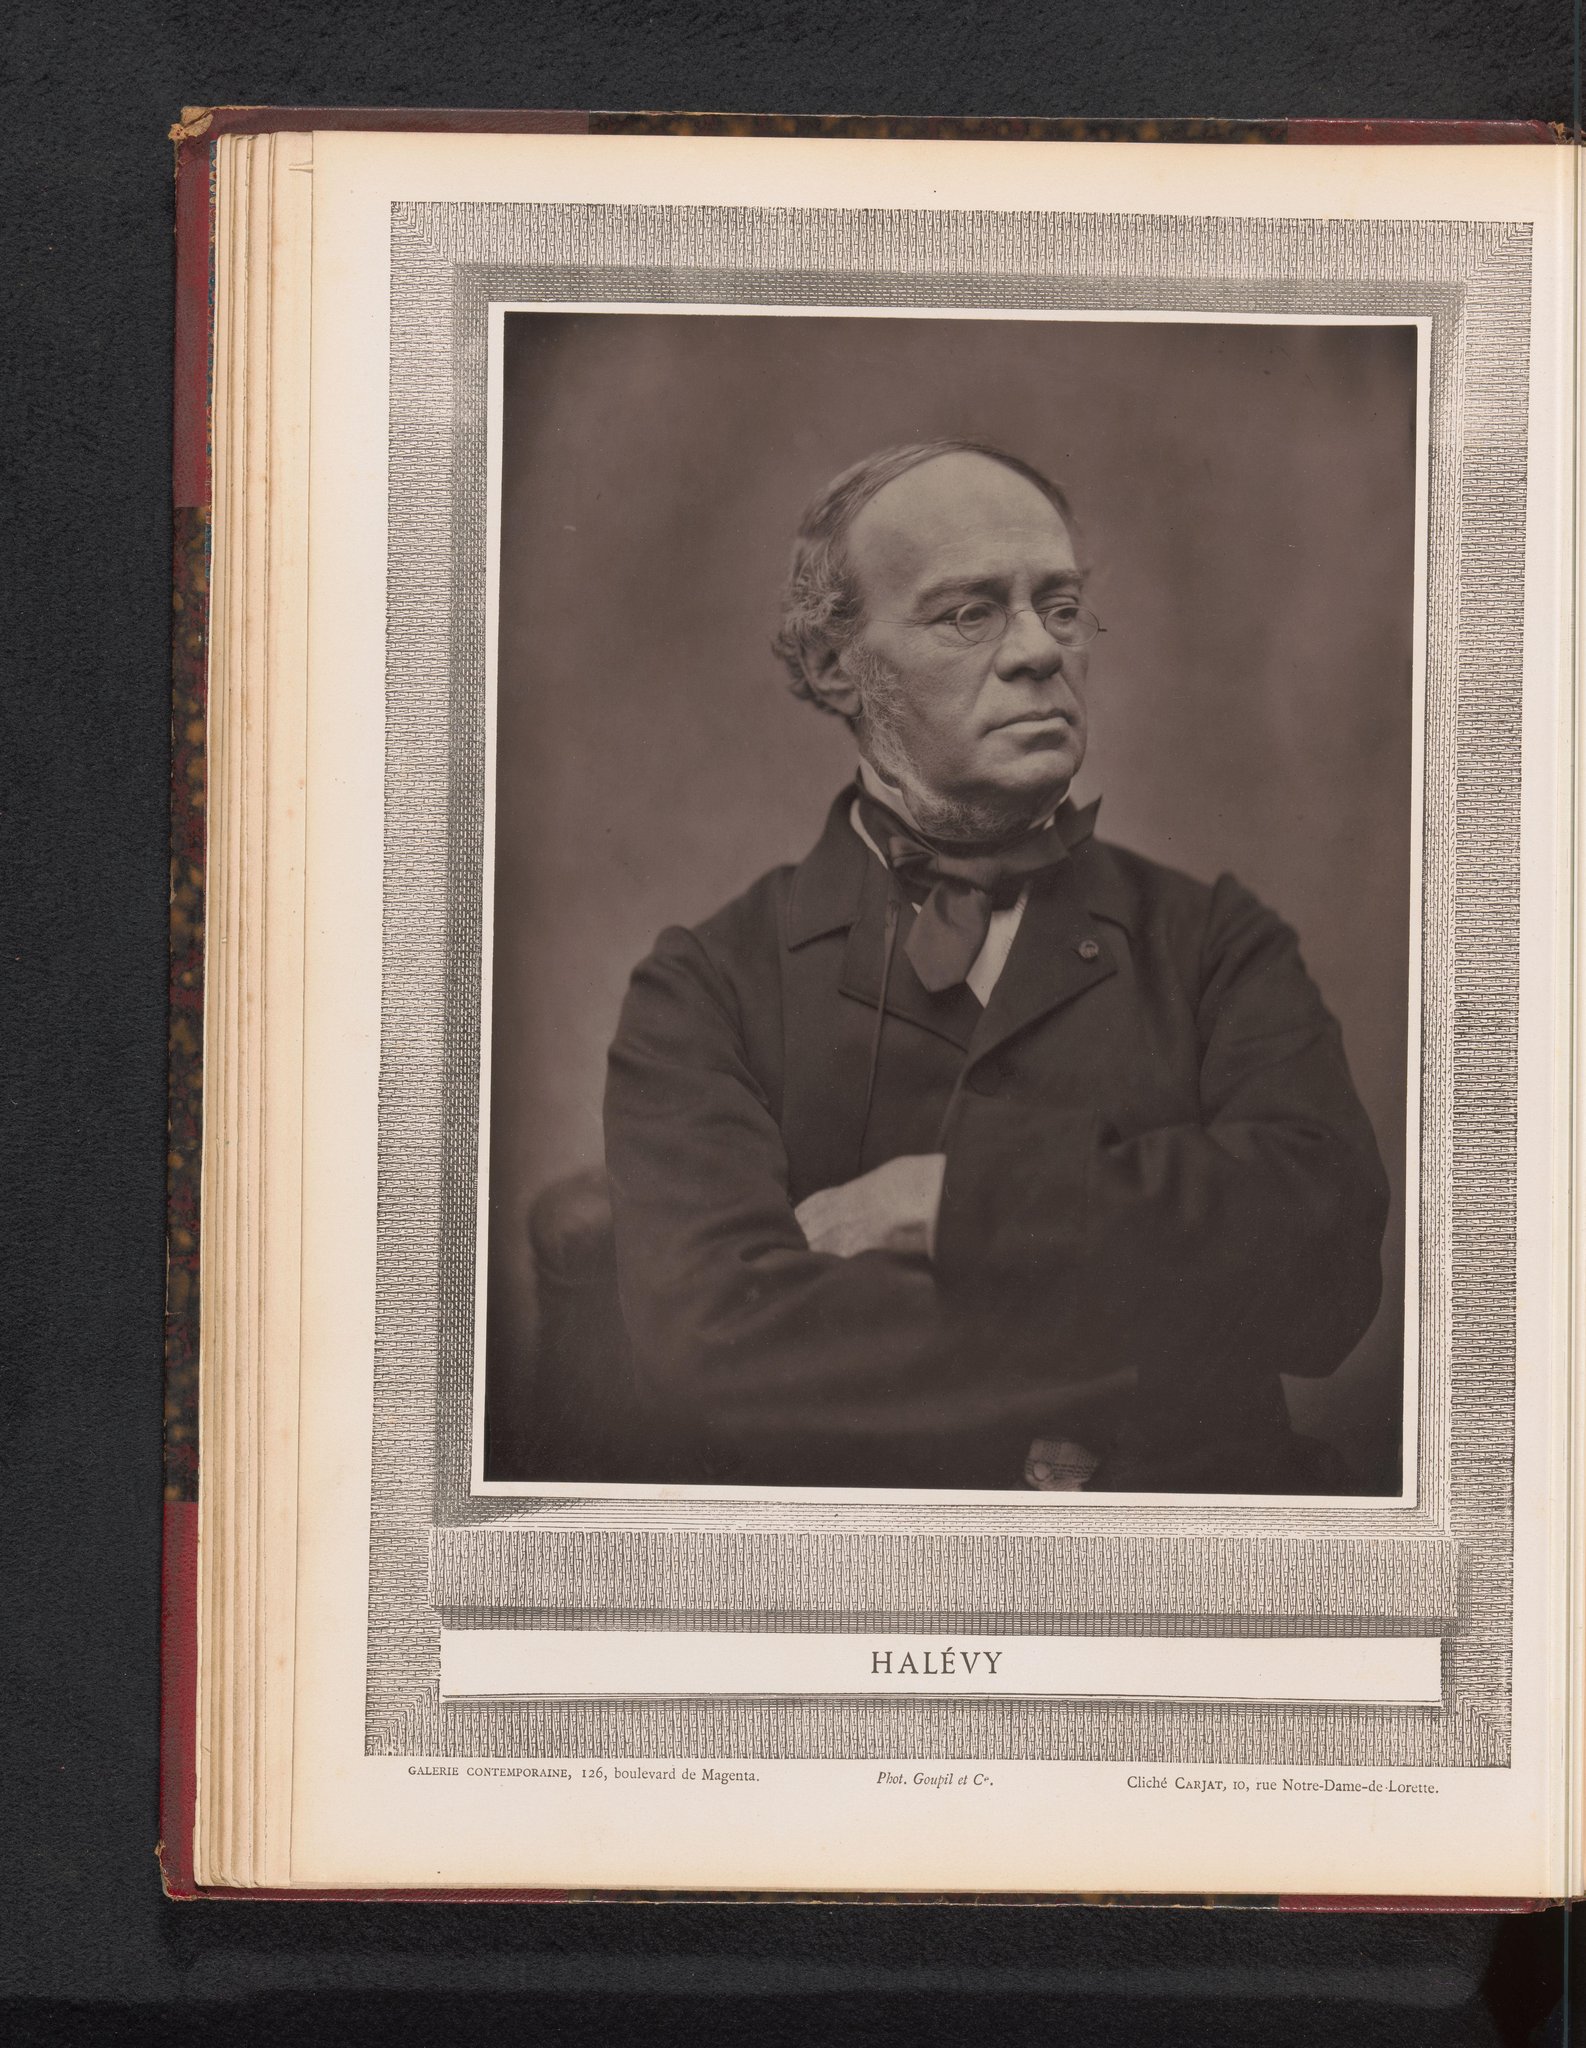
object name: photomechanical print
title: Halévy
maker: étienne carjat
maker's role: draughtsman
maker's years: 1828-1906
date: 1871-1876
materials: paper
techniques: woodburytype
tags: paris, adult man, historical persons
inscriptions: inscription: ‘Galerie Contemporaine, 126, boulevard de Magenta’